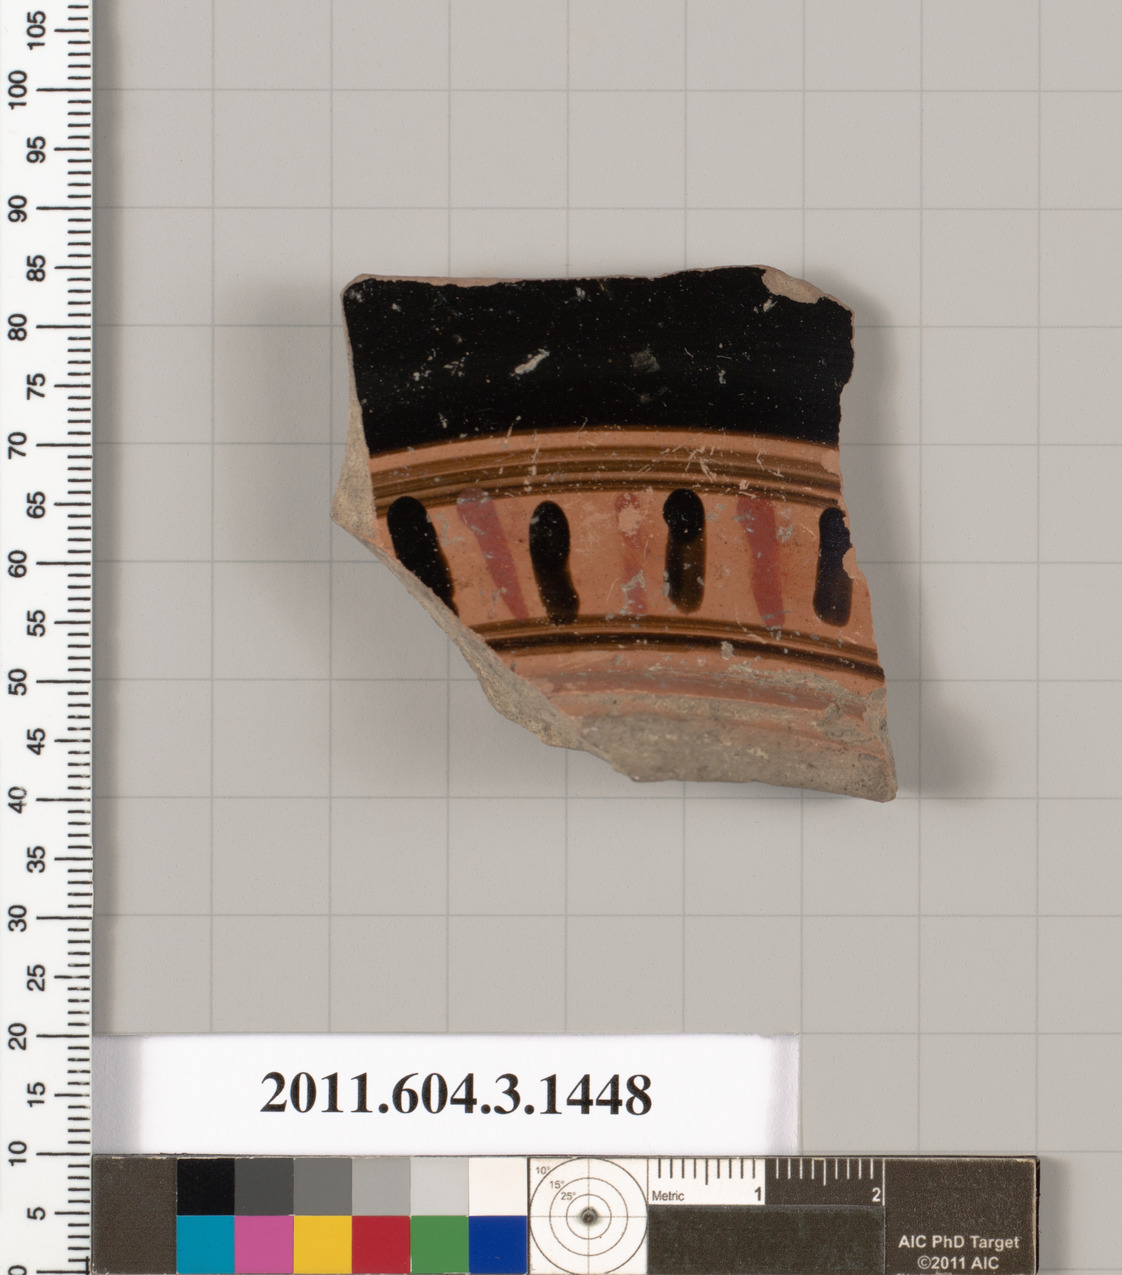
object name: skyphos fragment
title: Terracotta fragment of a skyphos (deep drinking cup)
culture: greek, attic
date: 534-468 BCE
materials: terracotta